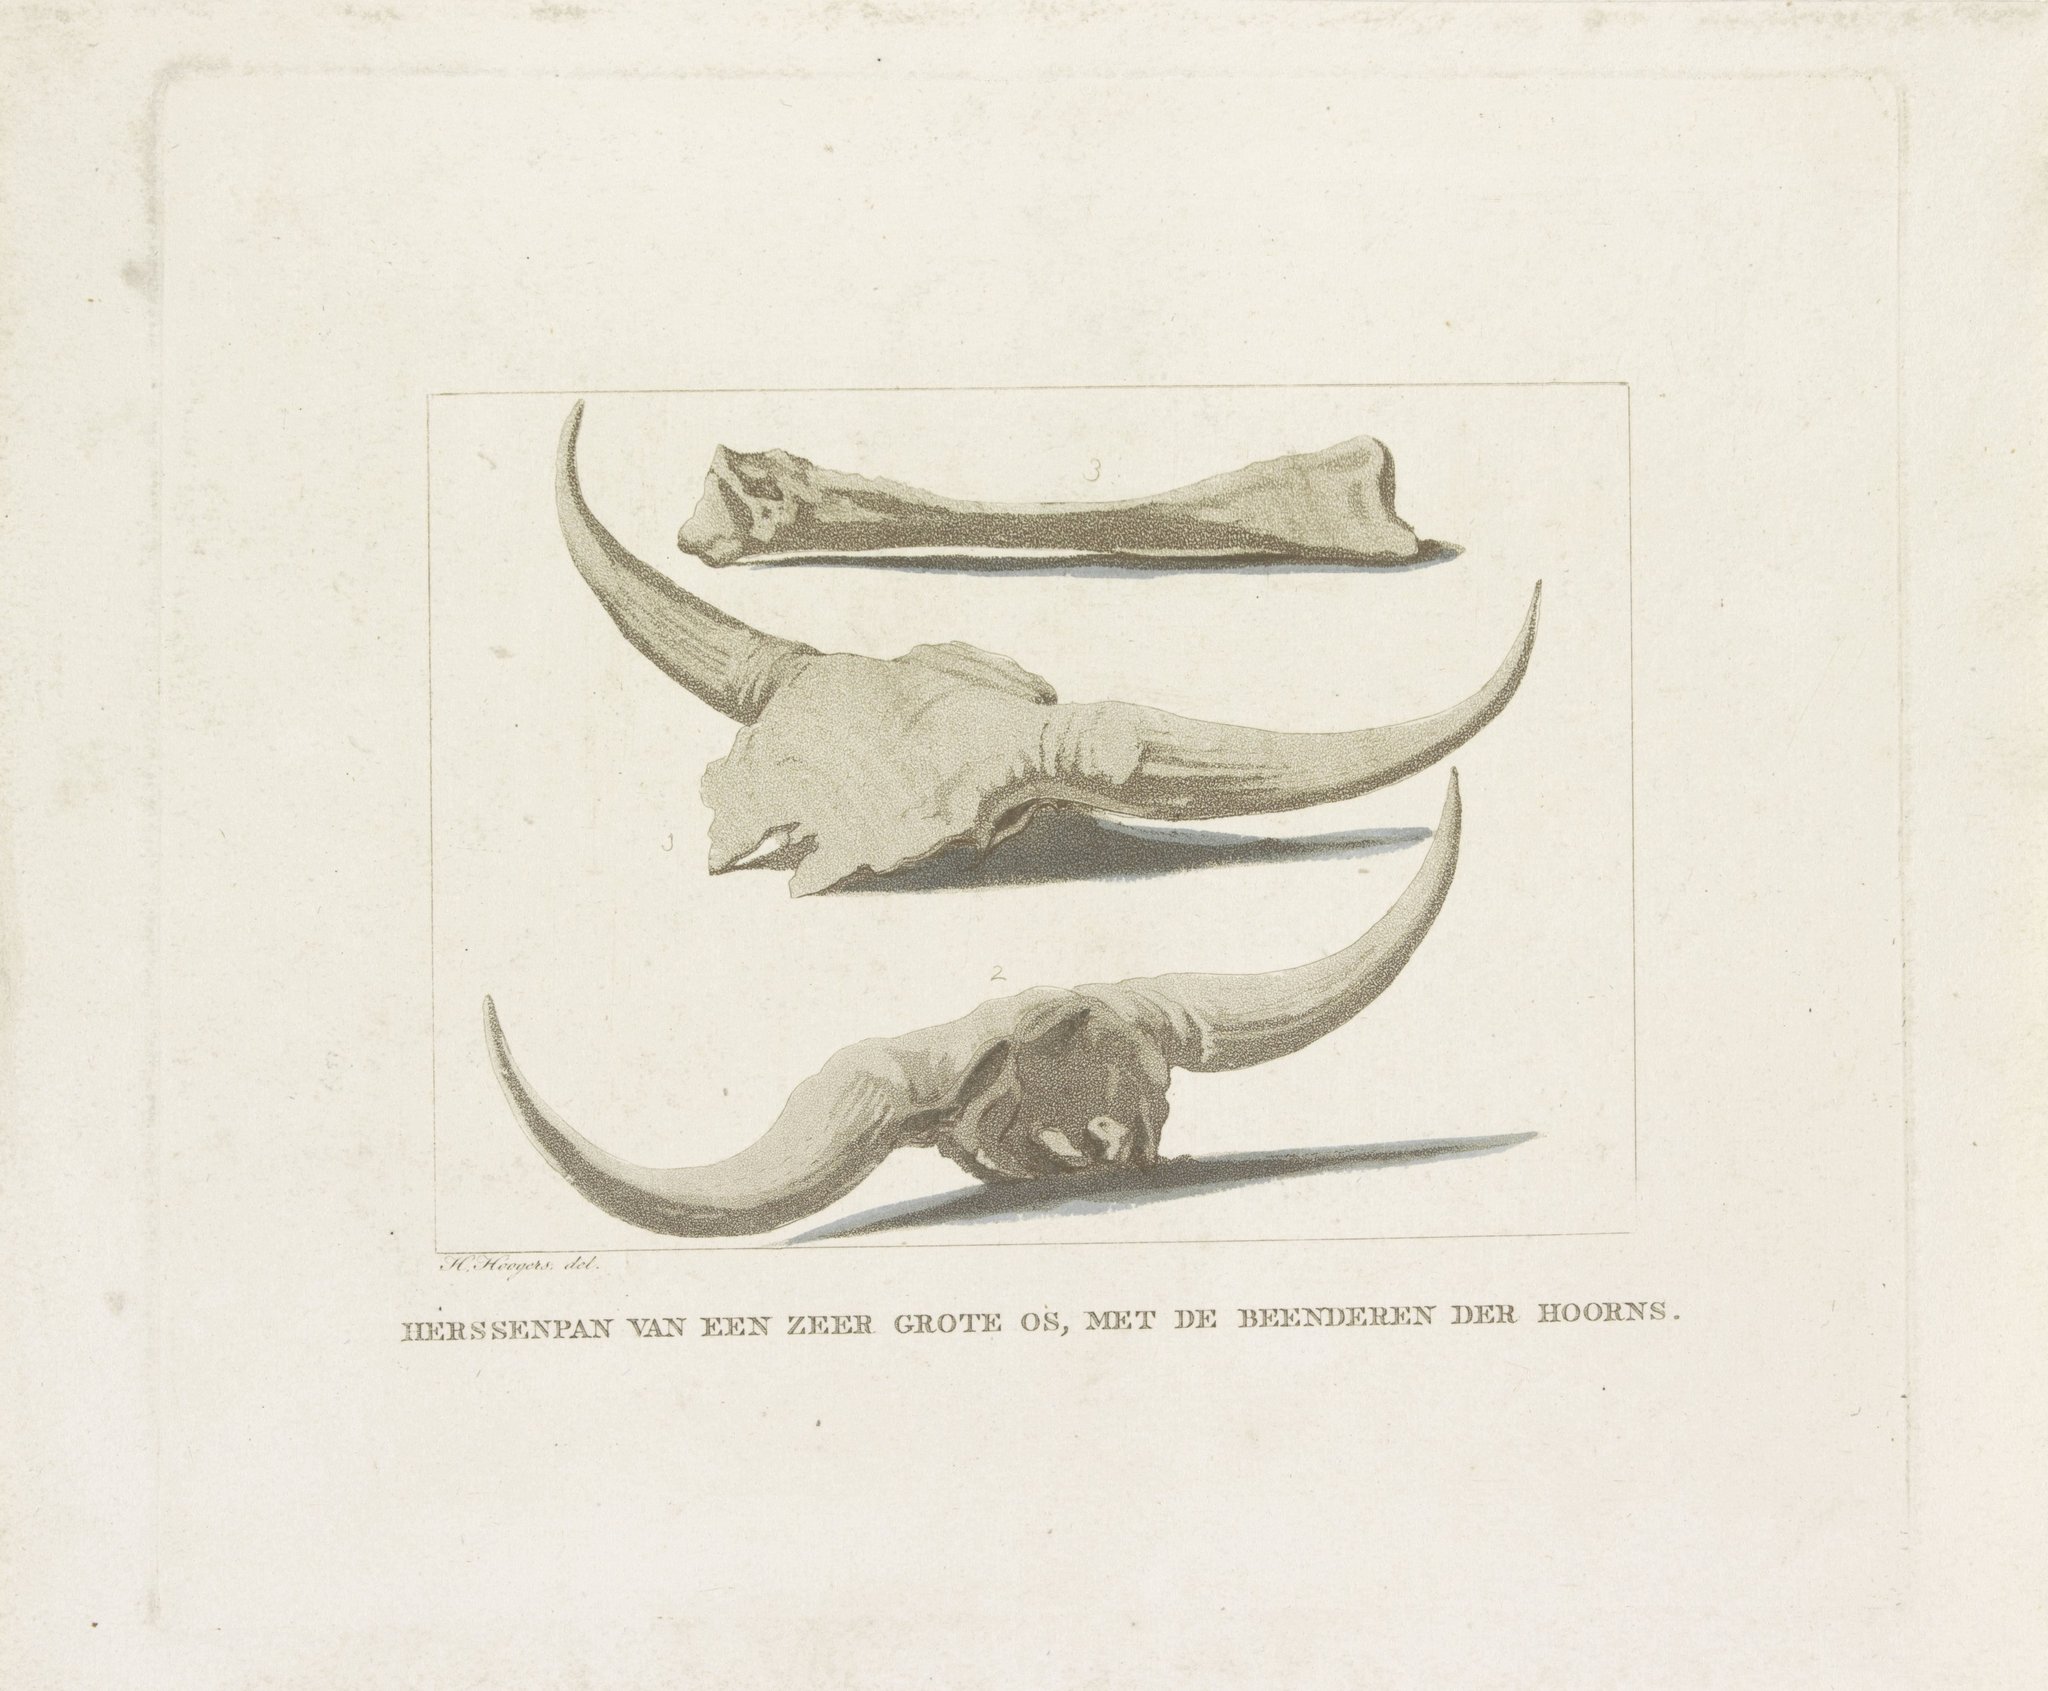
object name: print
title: Fossiele beenderen van een oeros, gevonden tijdens de watersnood, 1809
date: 1809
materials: paper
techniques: aquatint, etching, hand coloring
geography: netherlands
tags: fossil animals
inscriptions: collector's mark: Lugt 2228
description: Gebruikt als illustratie in: Hendrik Ewijk. Geschiedkundig verslag der dijkbreuken en overstroomingen, langs de rivieren in het Koningrijk Holland, voorgevallen in louwmaand MDCCCIX. 3 dln. Amsterdam: Johannes Allart en Jacobus Ruys, 1809.